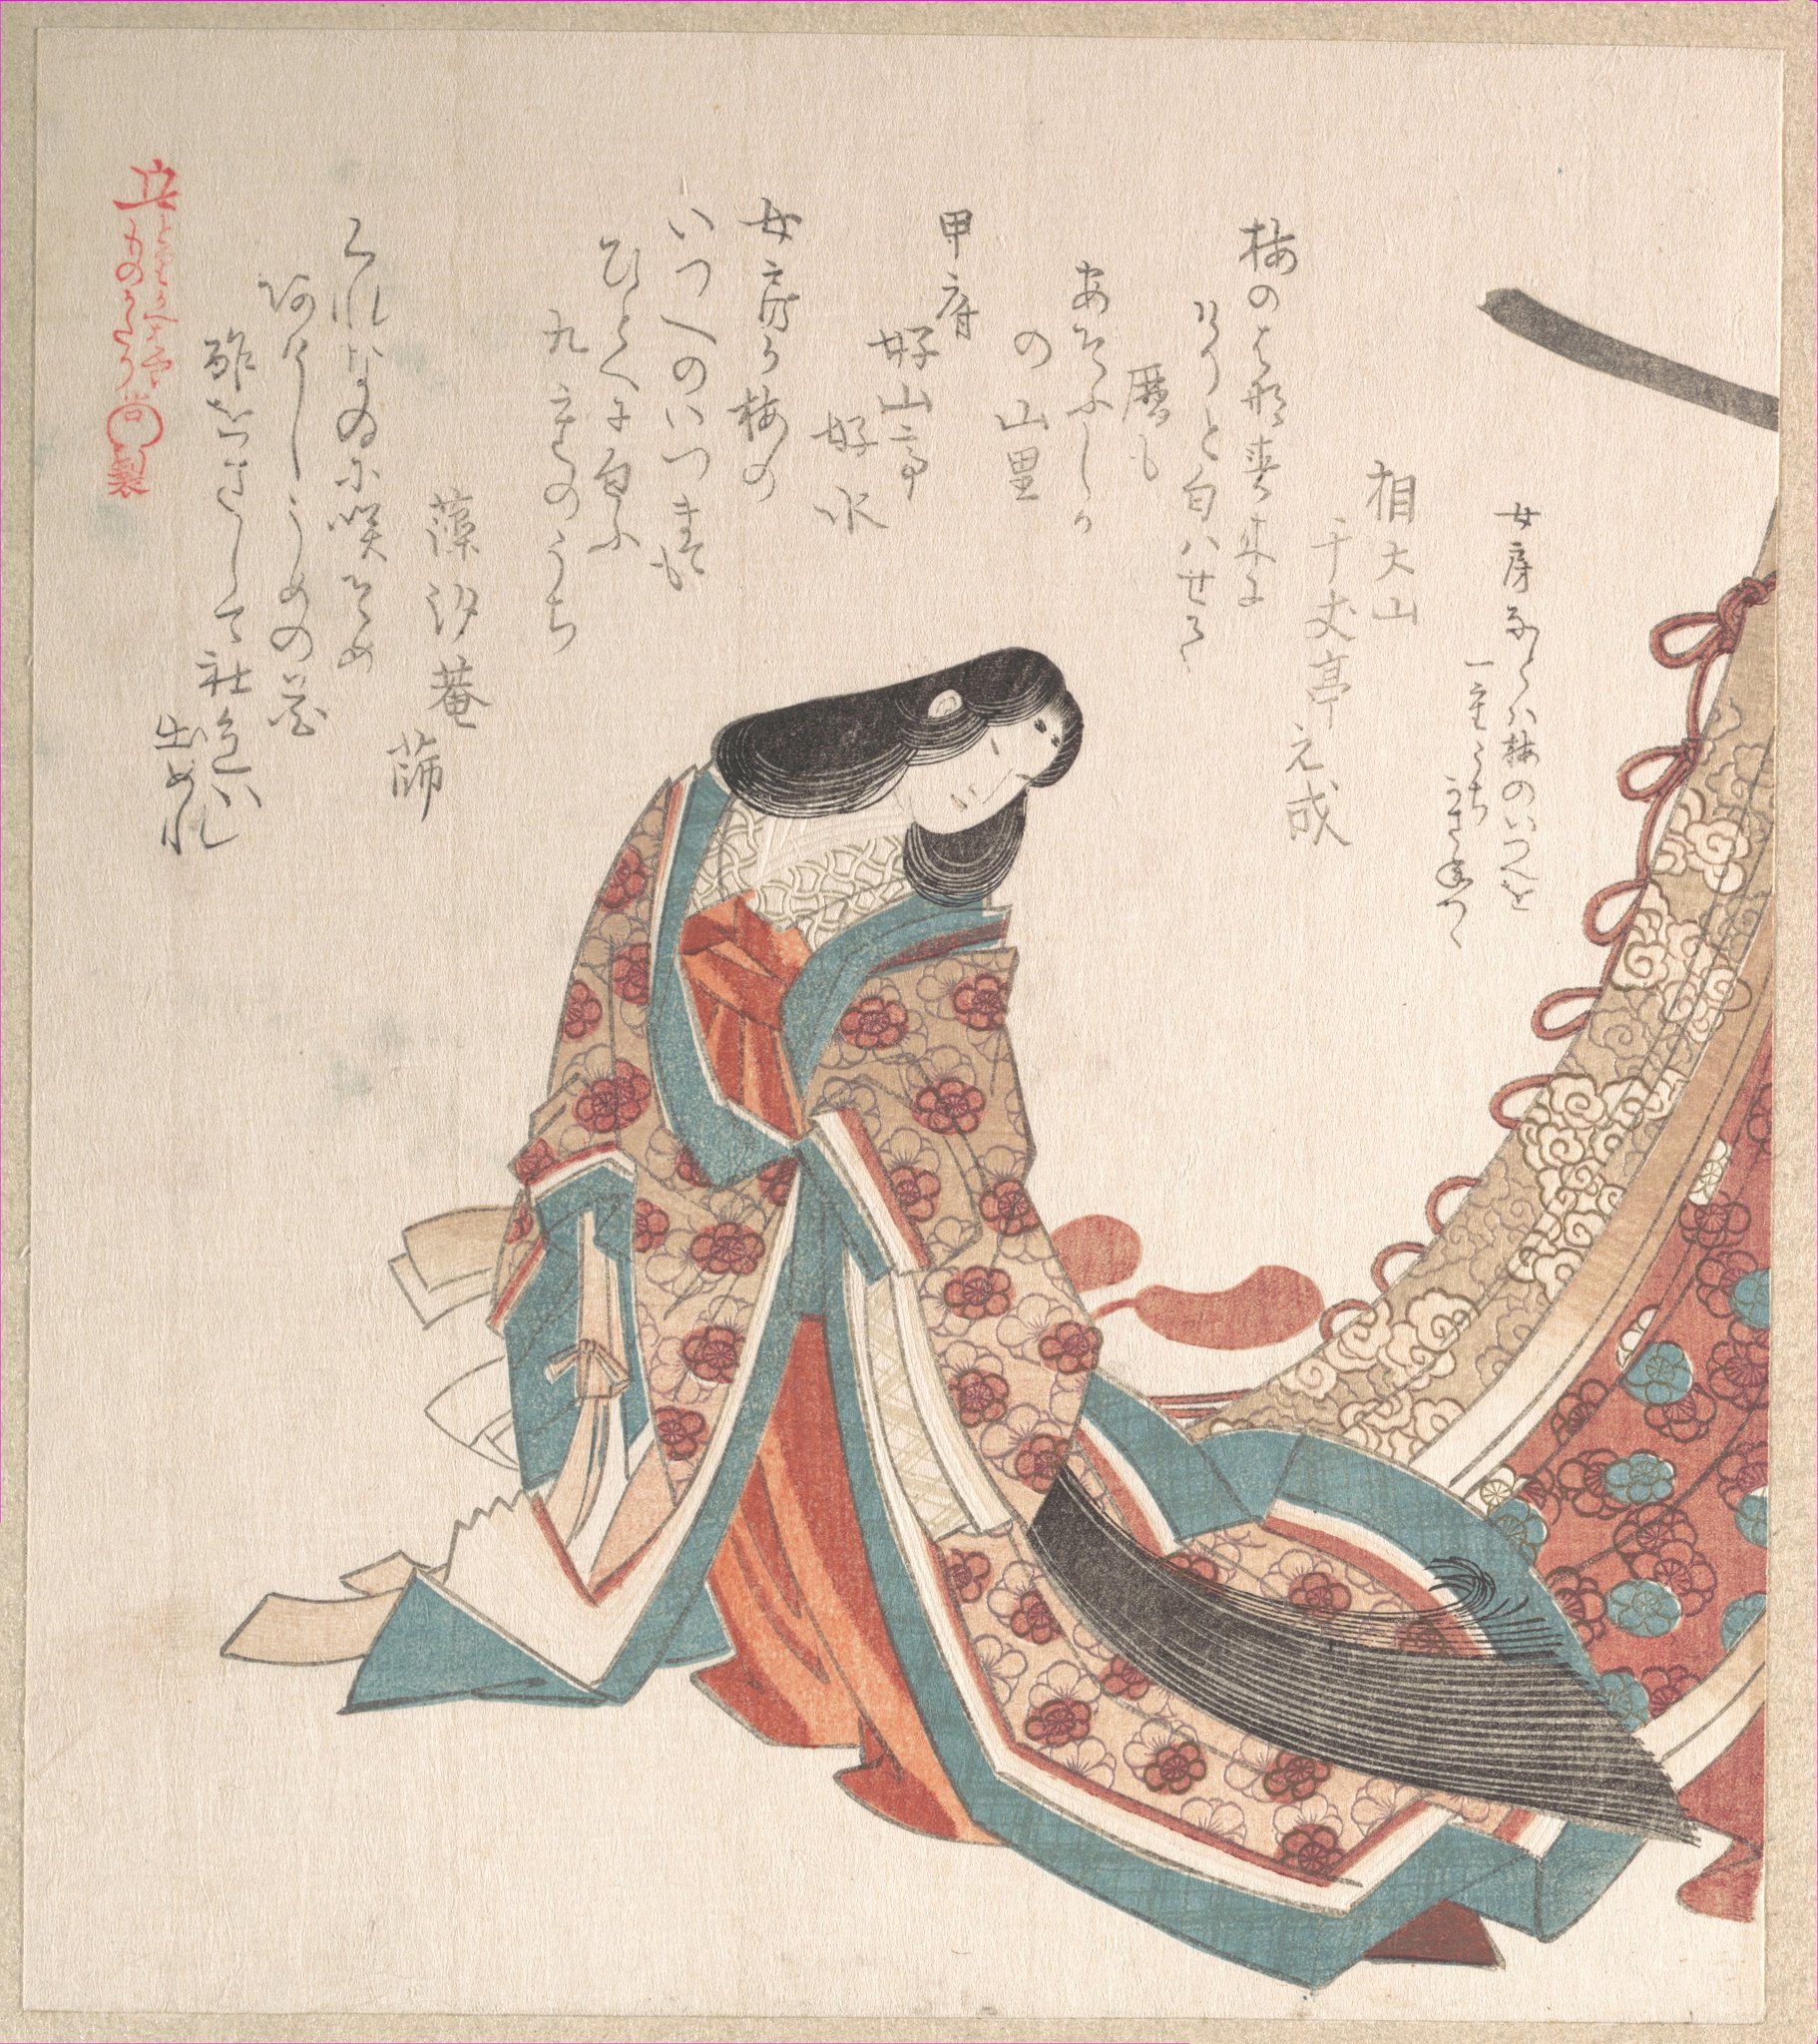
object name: print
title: Young Court Lady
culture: japanese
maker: kubo shunman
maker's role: artist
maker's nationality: japanese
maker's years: 1757-1820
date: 1801-1900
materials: ink, paper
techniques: surimono, woodblock print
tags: women